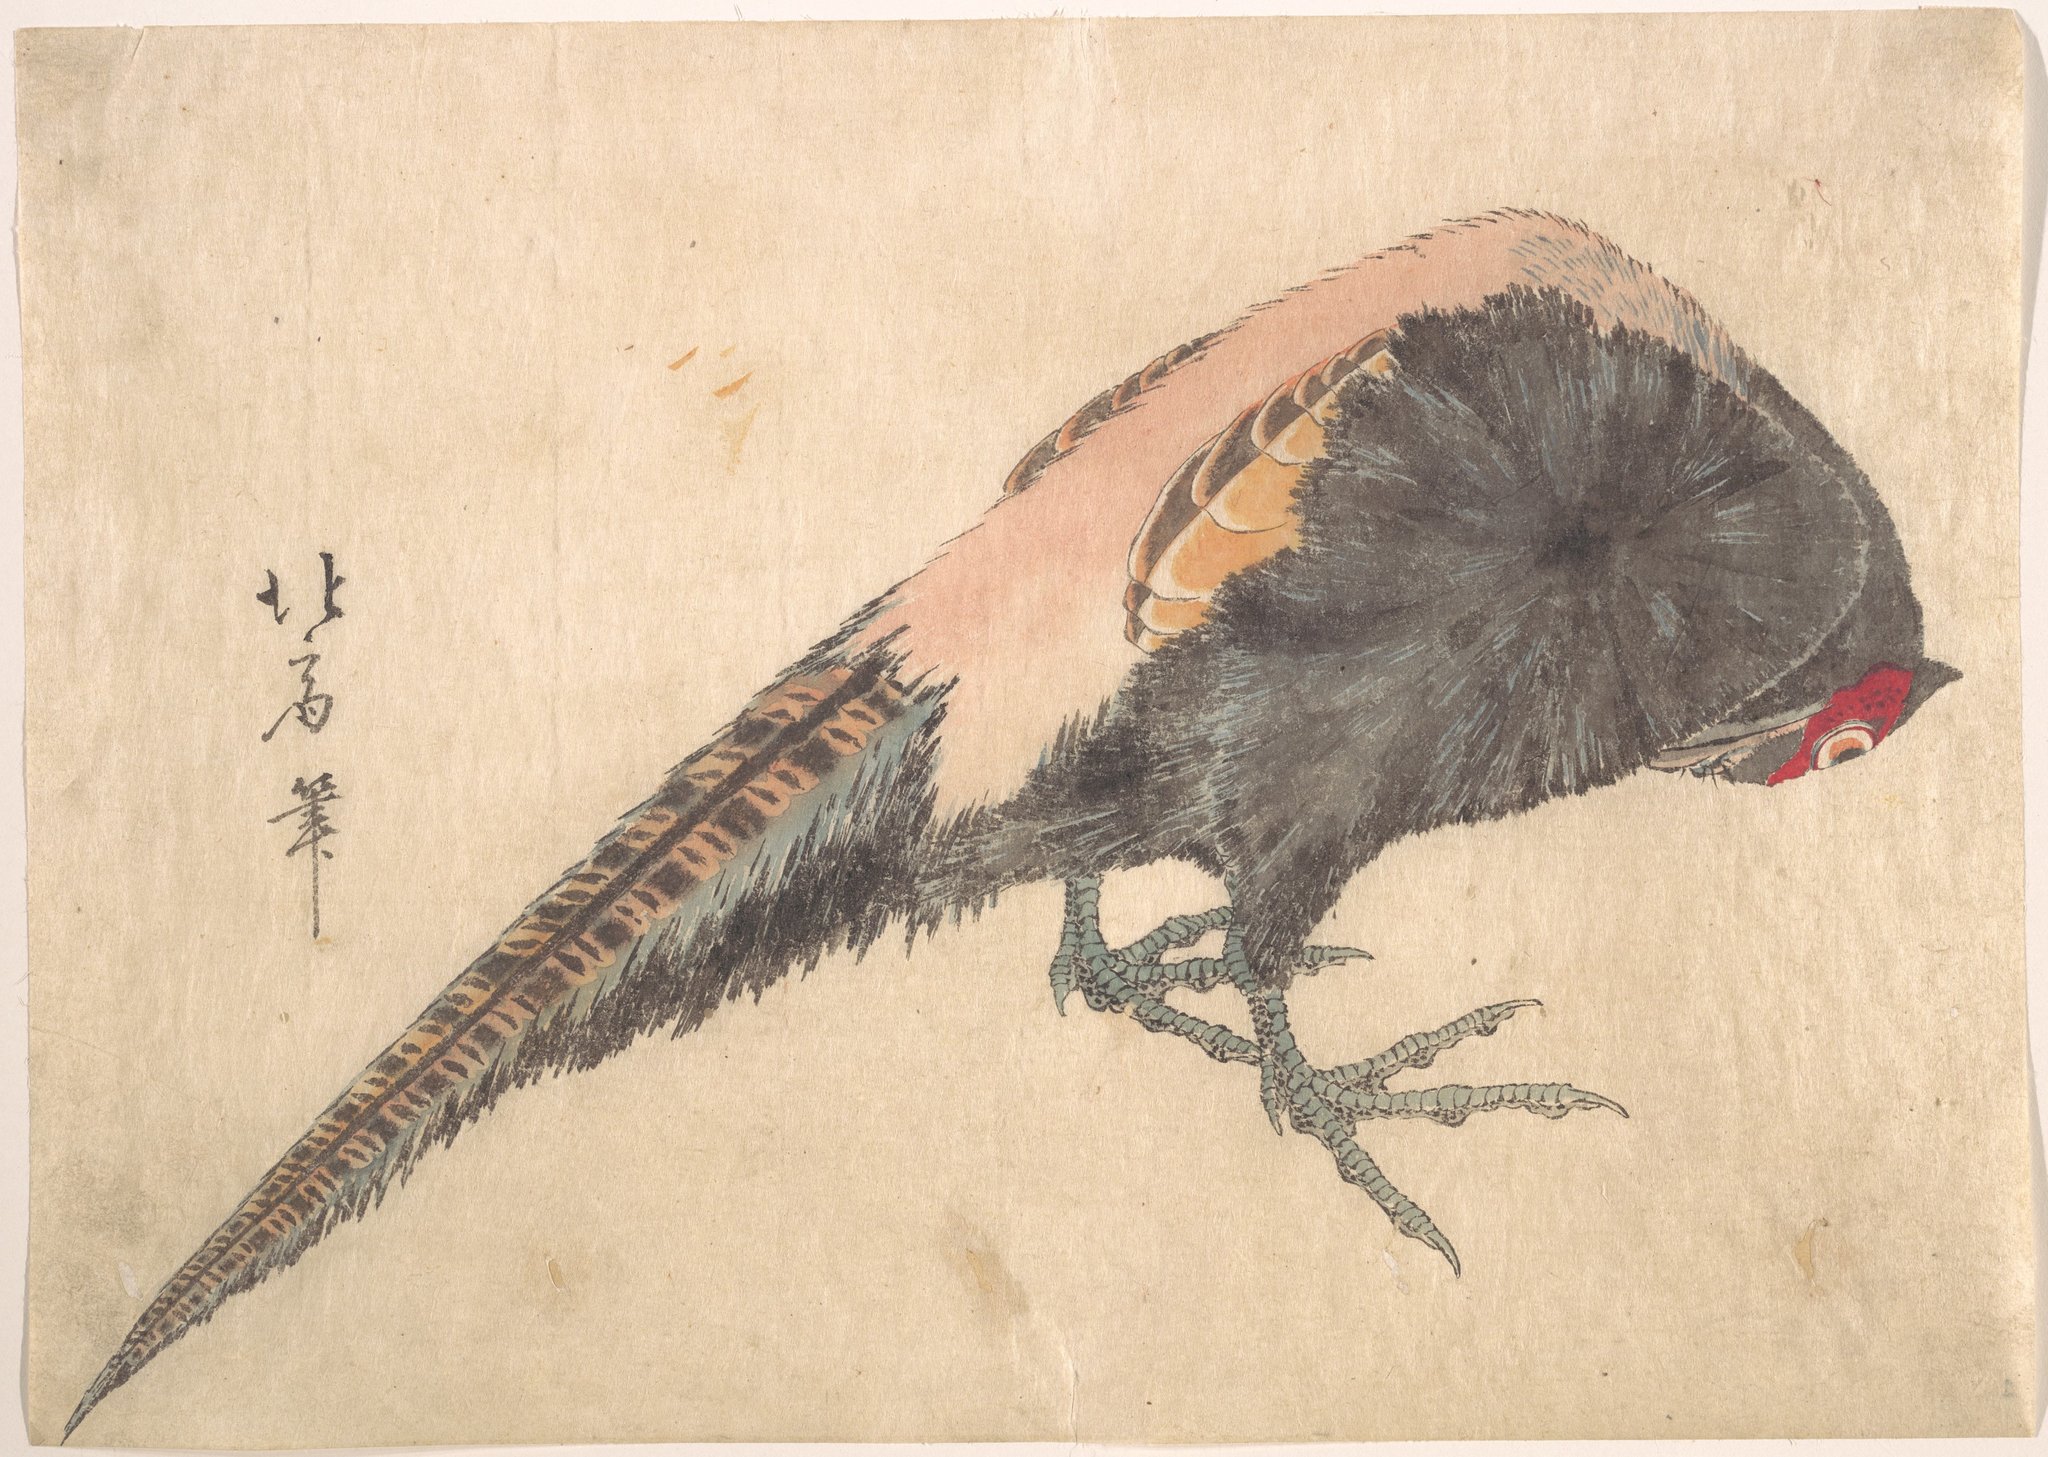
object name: print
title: Bird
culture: japanese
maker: hakusanjin hokui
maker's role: artist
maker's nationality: japanese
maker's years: 1830-1840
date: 1830-1840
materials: ink, paper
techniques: woodblock print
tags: birds